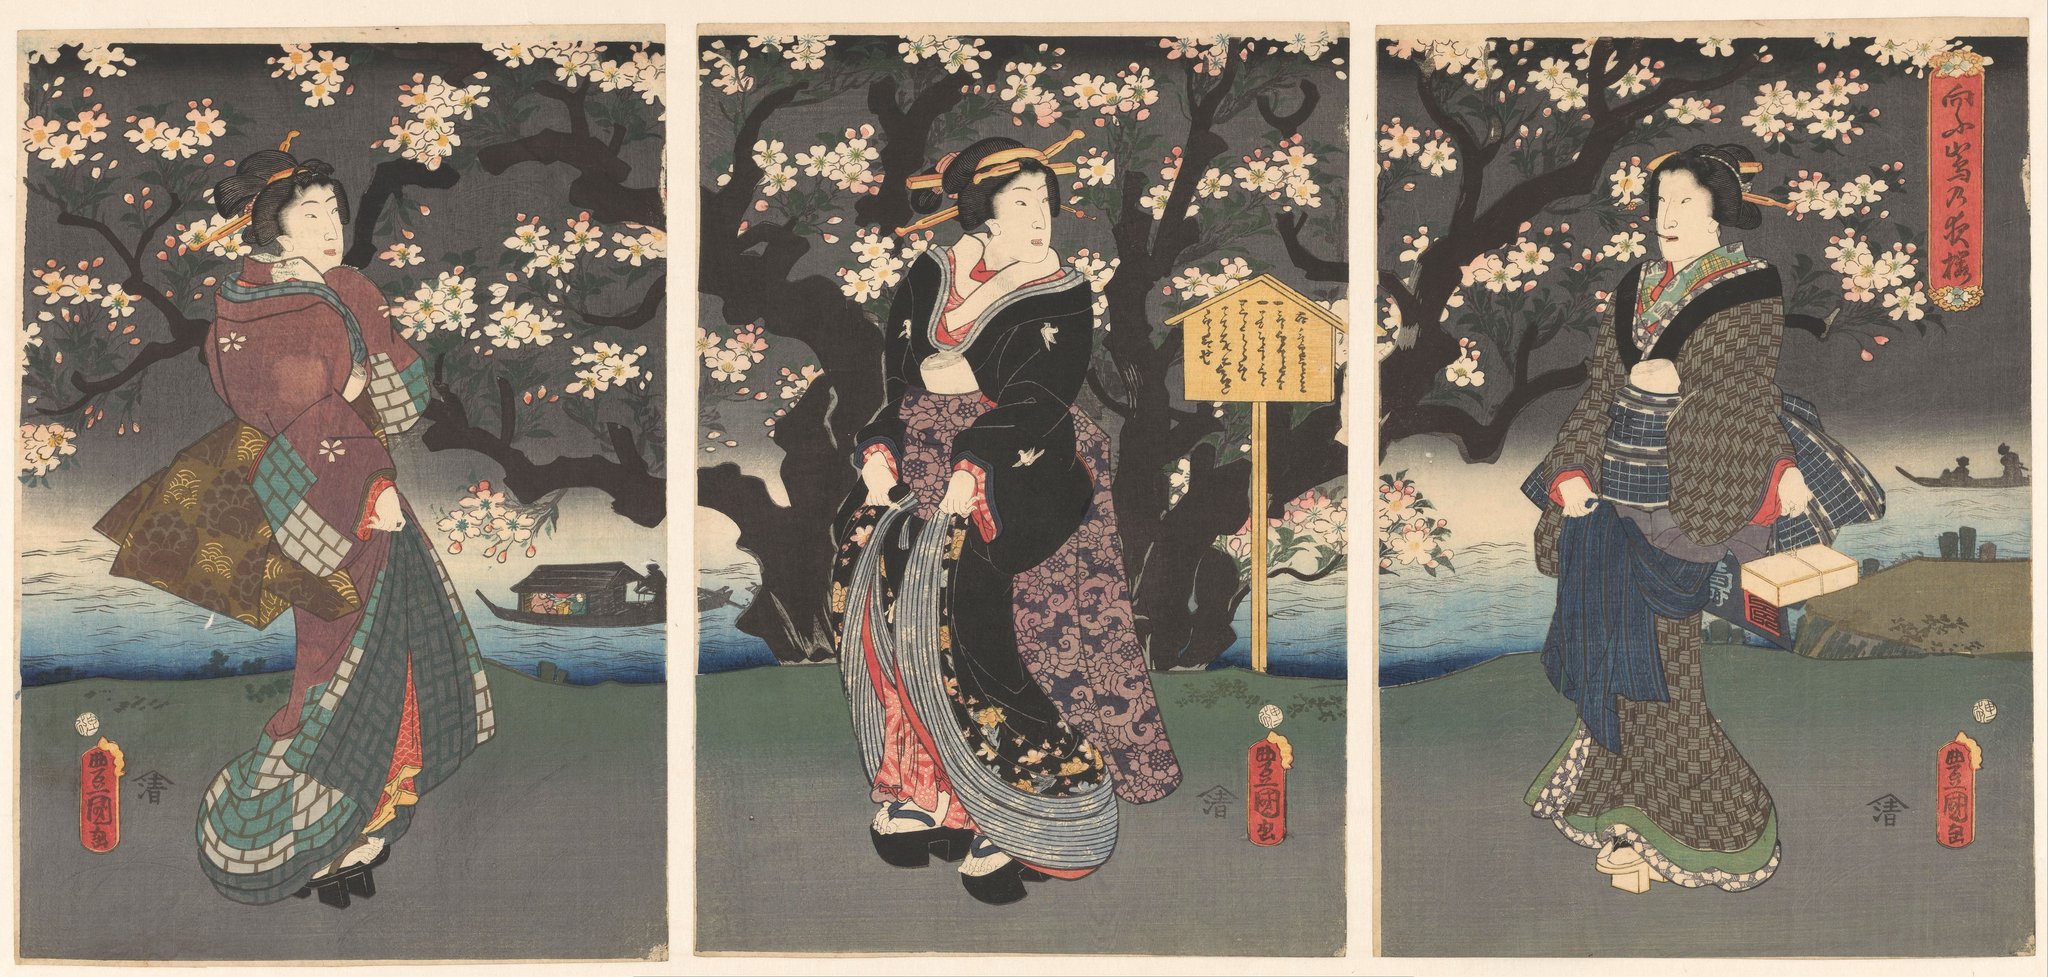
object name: triptych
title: Avond wandeling langs de rivier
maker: utagawa kunisada (i)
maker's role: print maker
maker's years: 1786-1865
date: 1802-1860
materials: paper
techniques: woodcut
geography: japan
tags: trees, river bank, adult woman (+ three persons)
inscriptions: date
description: Avondscene met drie vrouwen op rivieroever, bij grote, grillige boom met bloesem.